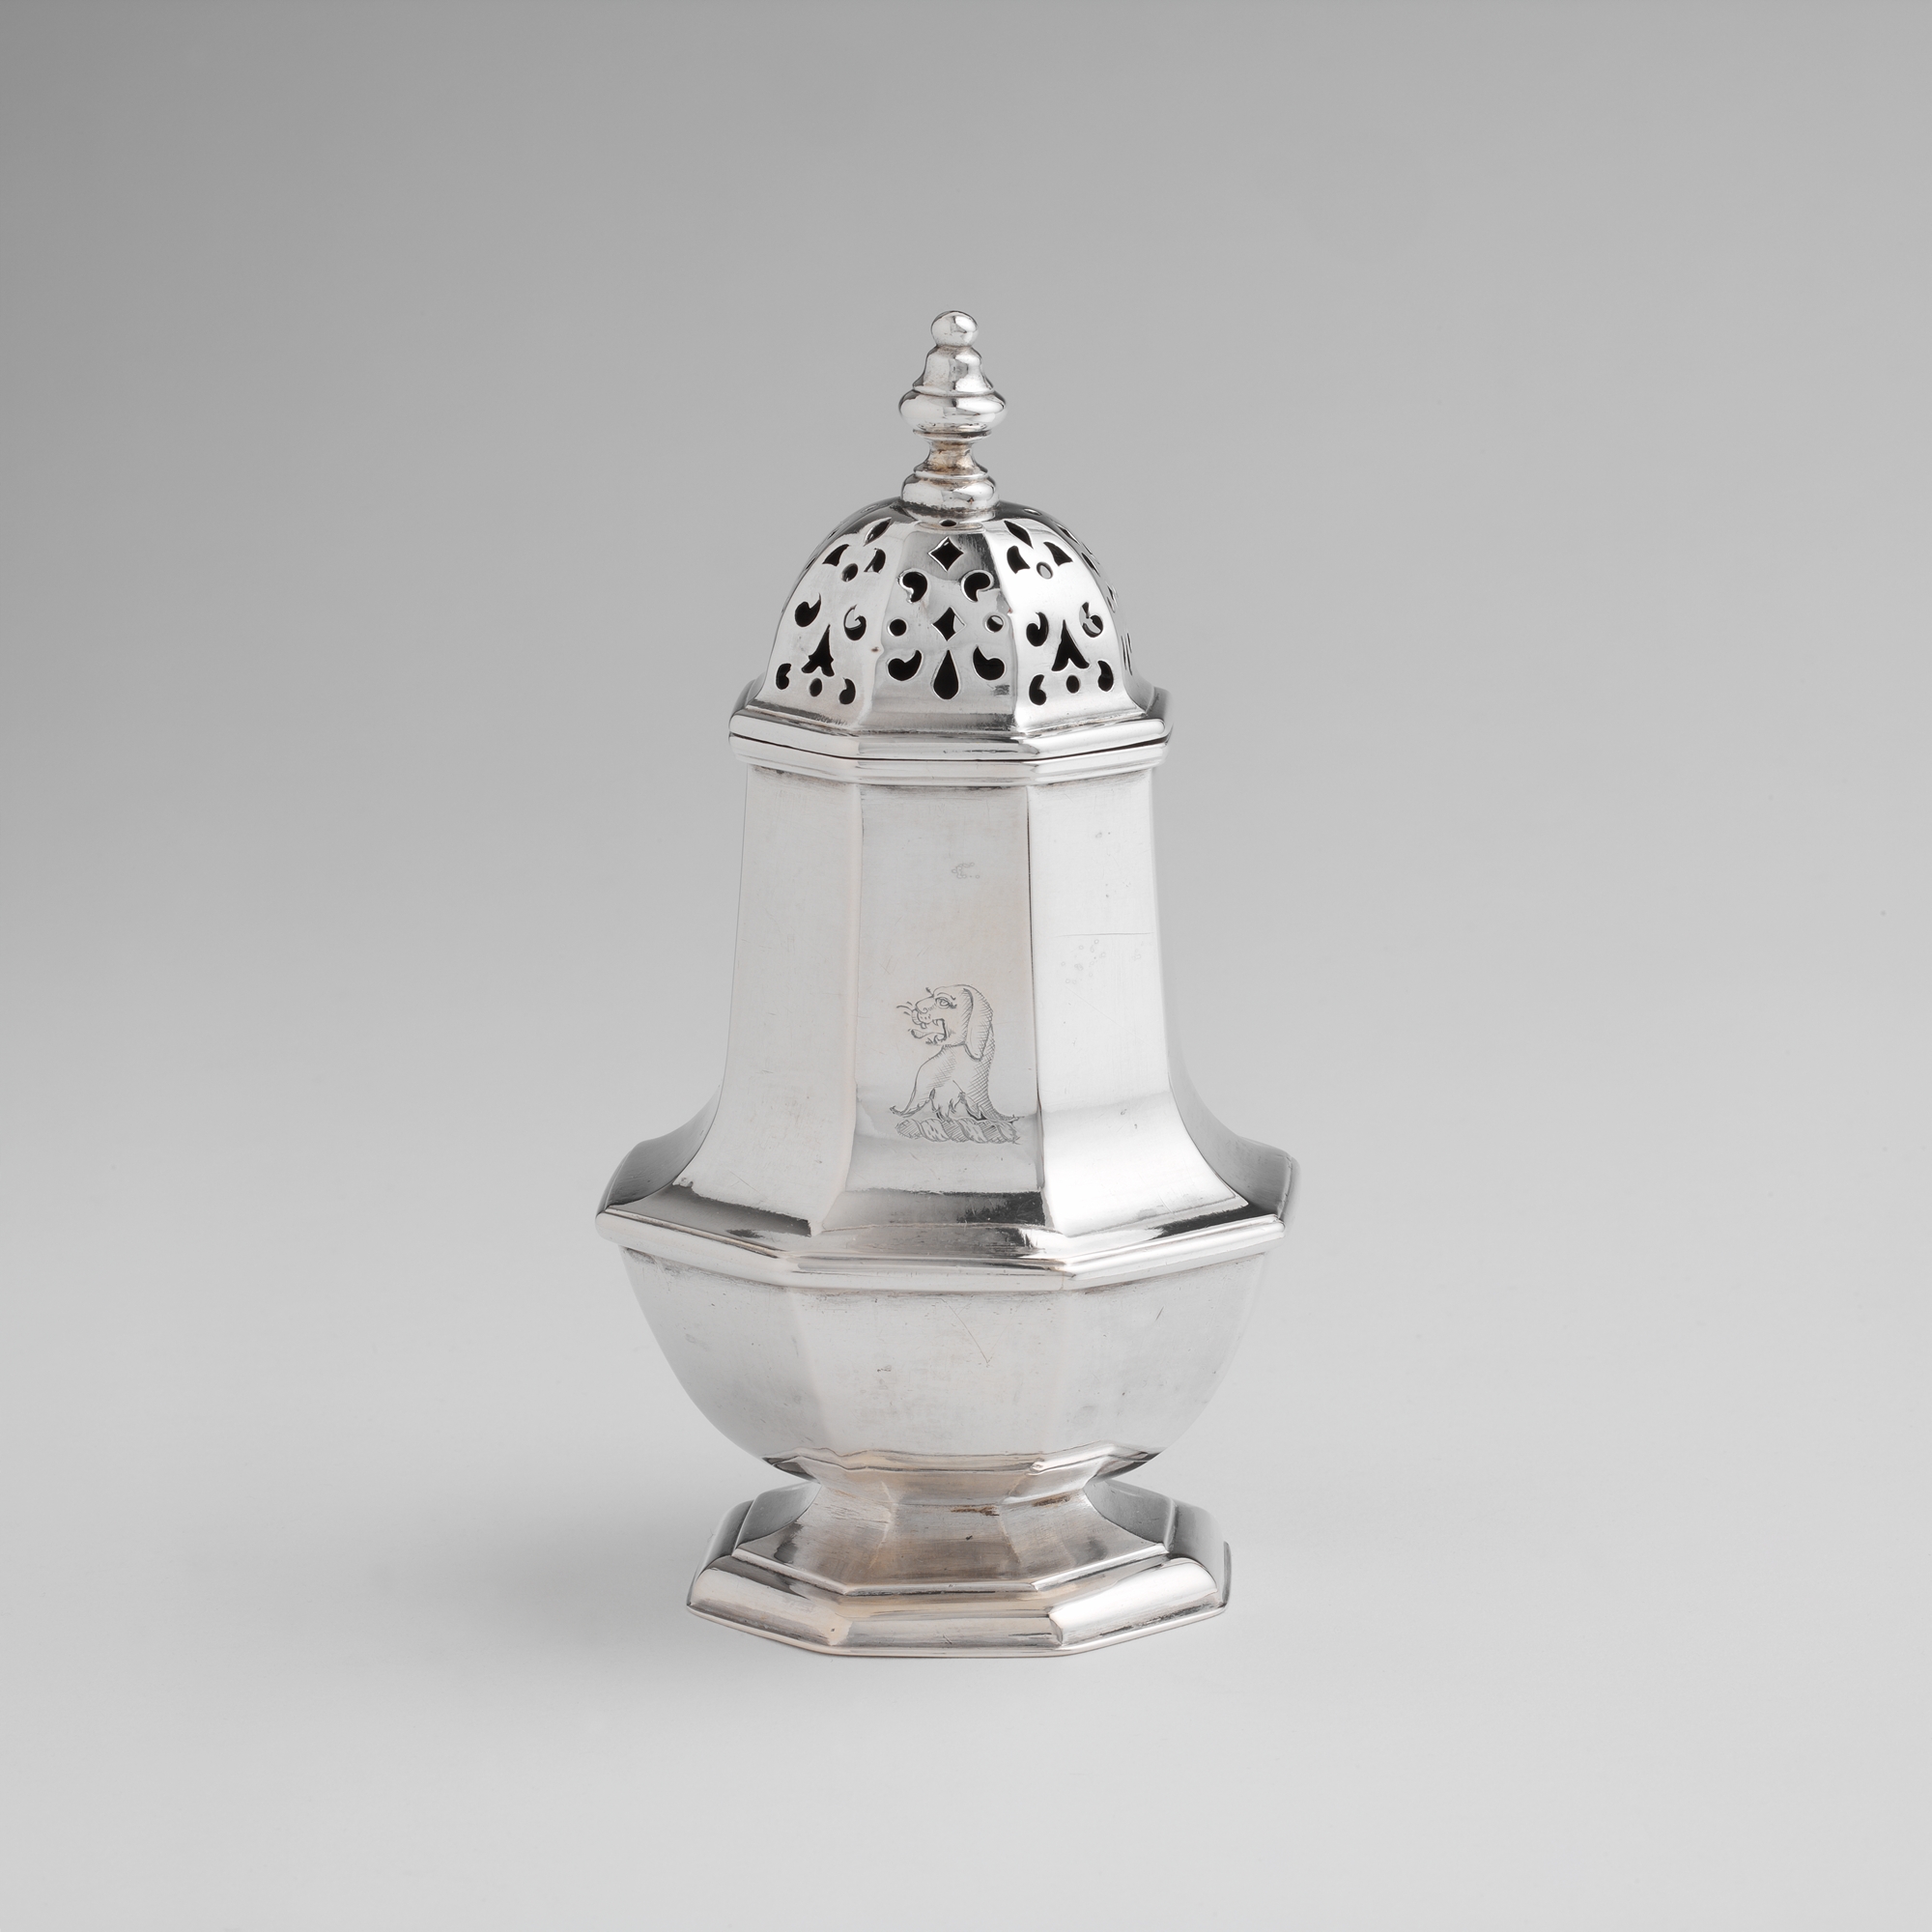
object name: caster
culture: american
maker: knight leverett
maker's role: maker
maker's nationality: american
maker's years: 1702-1753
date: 1735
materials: silver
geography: united states